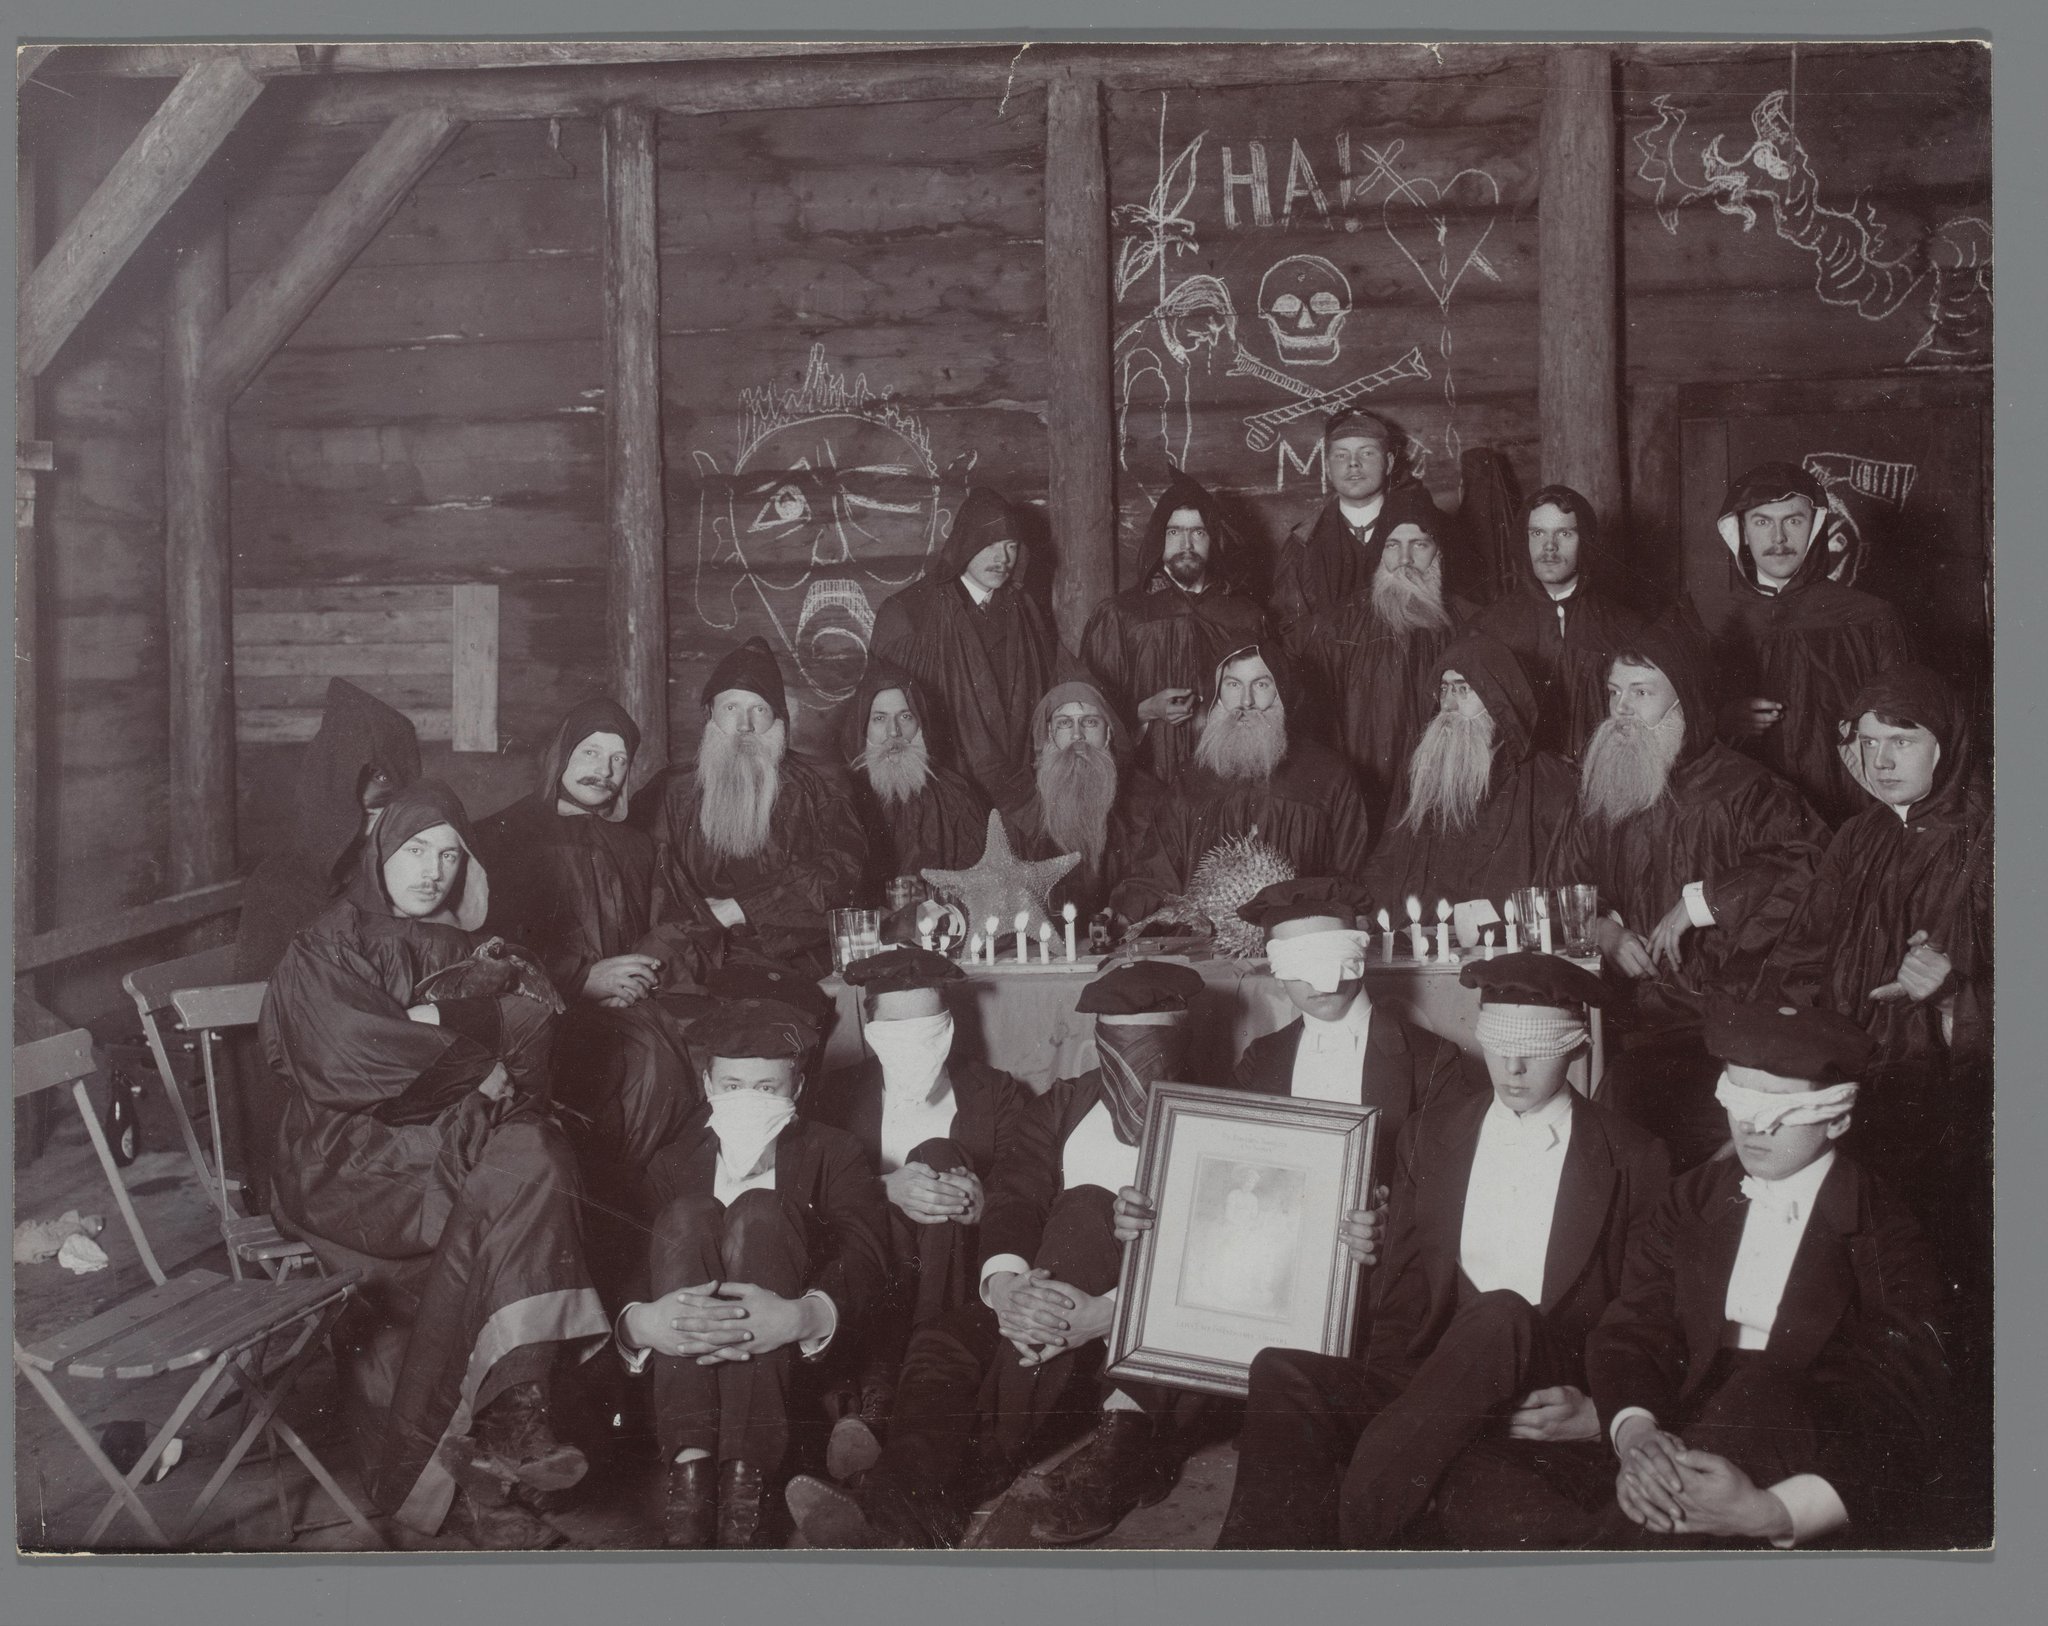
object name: photograph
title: Inauguratie van nieuwe leden bij een studentenvereniging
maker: Anonymous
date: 1905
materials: photographic support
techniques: gelatin silver print